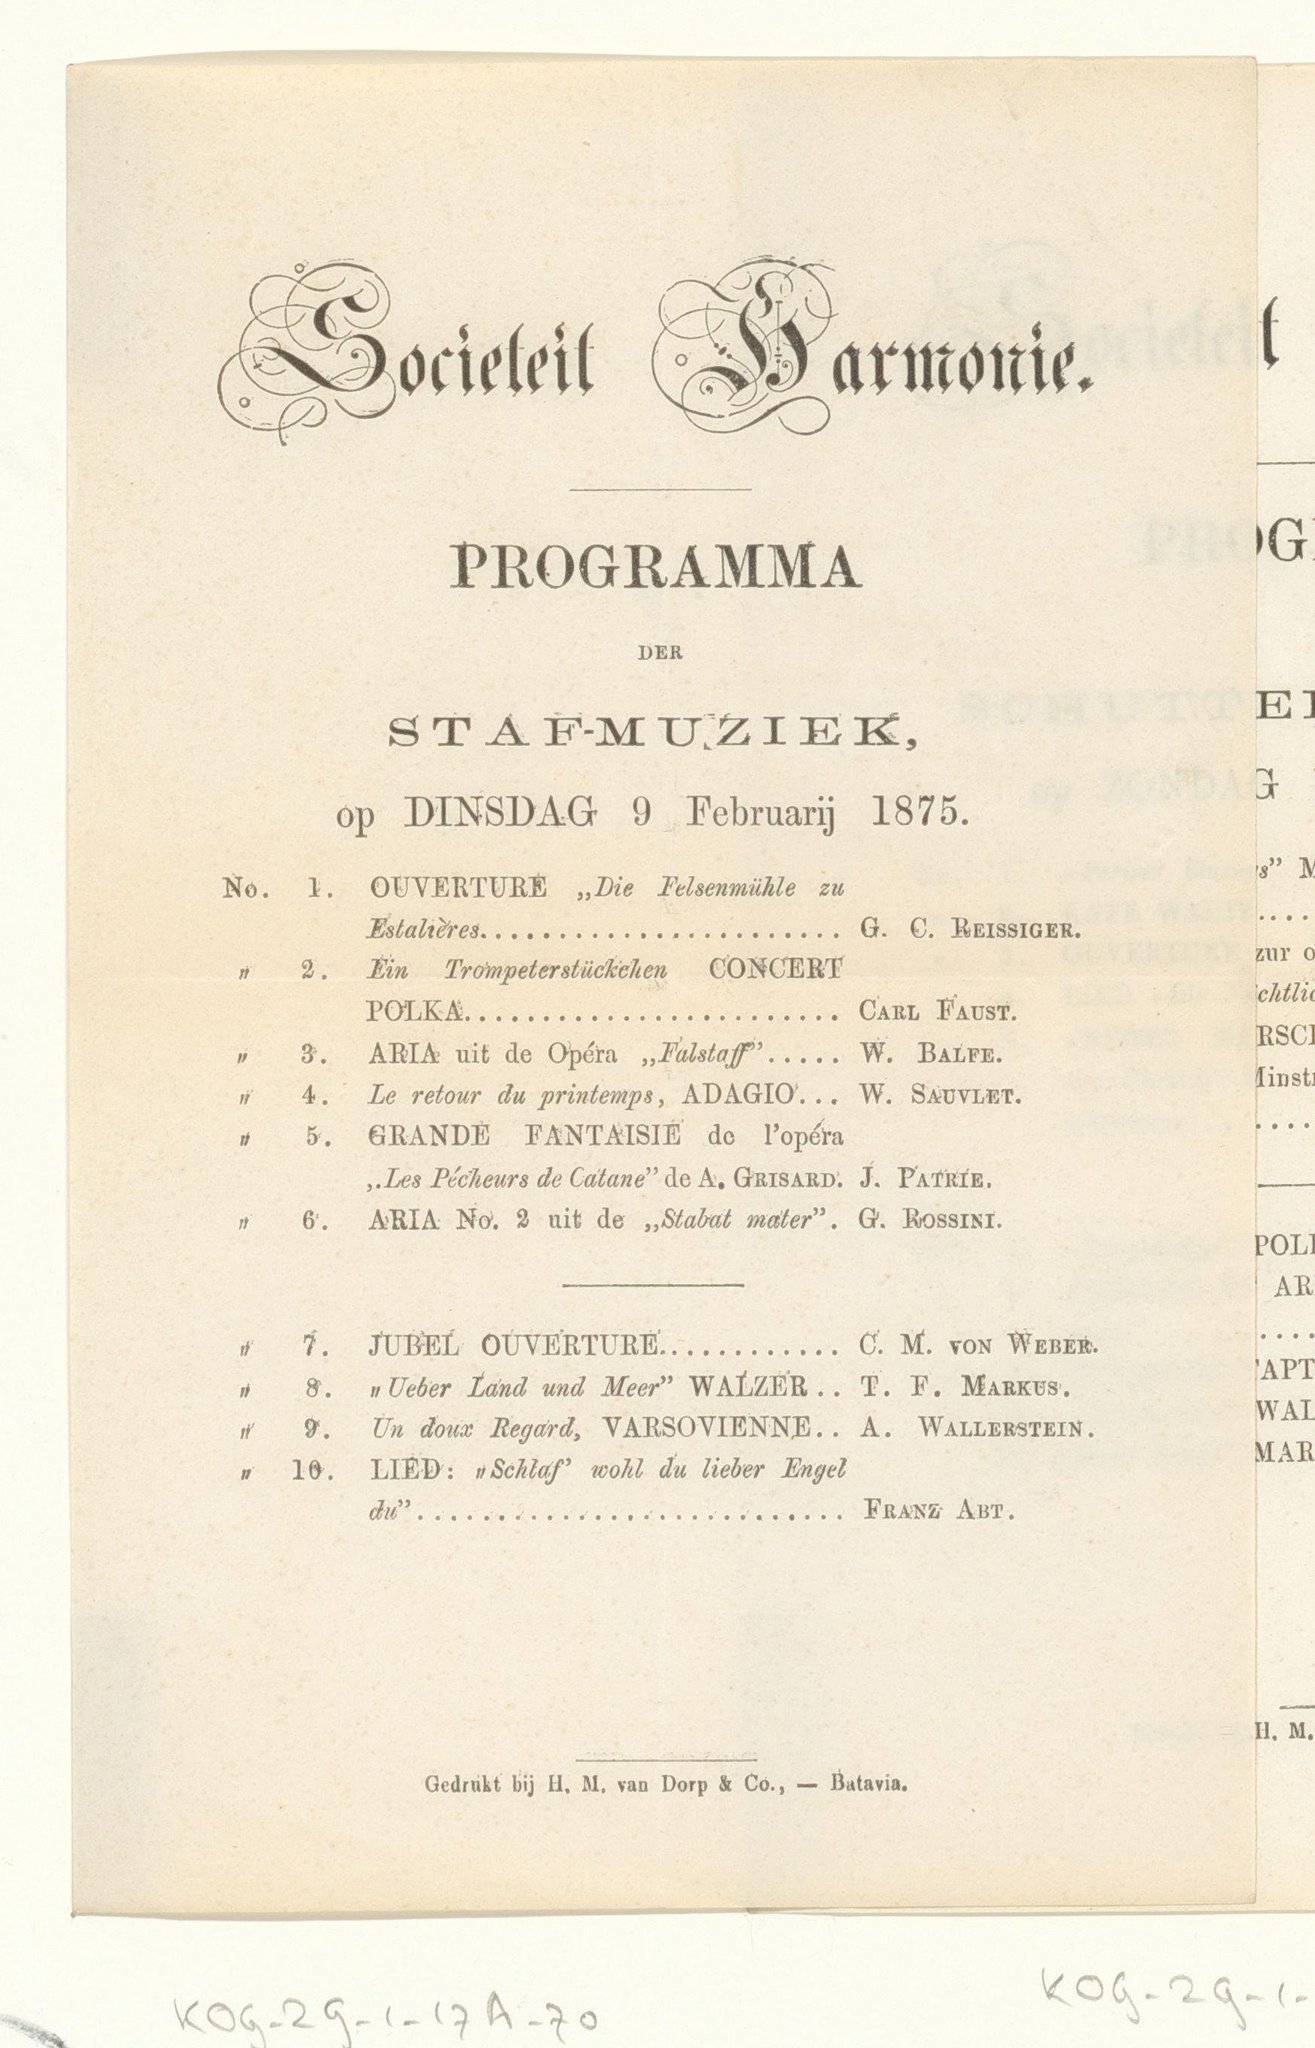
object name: text sheet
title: Programma voor een concert in Sociëteit Harmonie op 9 februari 1875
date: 1875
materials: paper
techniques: letterpress printing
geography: batavia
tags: listening to music, large group of musicians, orchestra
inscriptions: collector's mark, collector's mark: Lugt 1641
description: Gedrukt programma voor een concert van stafmuziek in de Sociëteit Harmonie te Batavia op 9 februari 1875. Onderwerpsrubrieken binnen de Atlas Zeden en Gewoonten: Muziek en muziekinstrumenten: Varia.